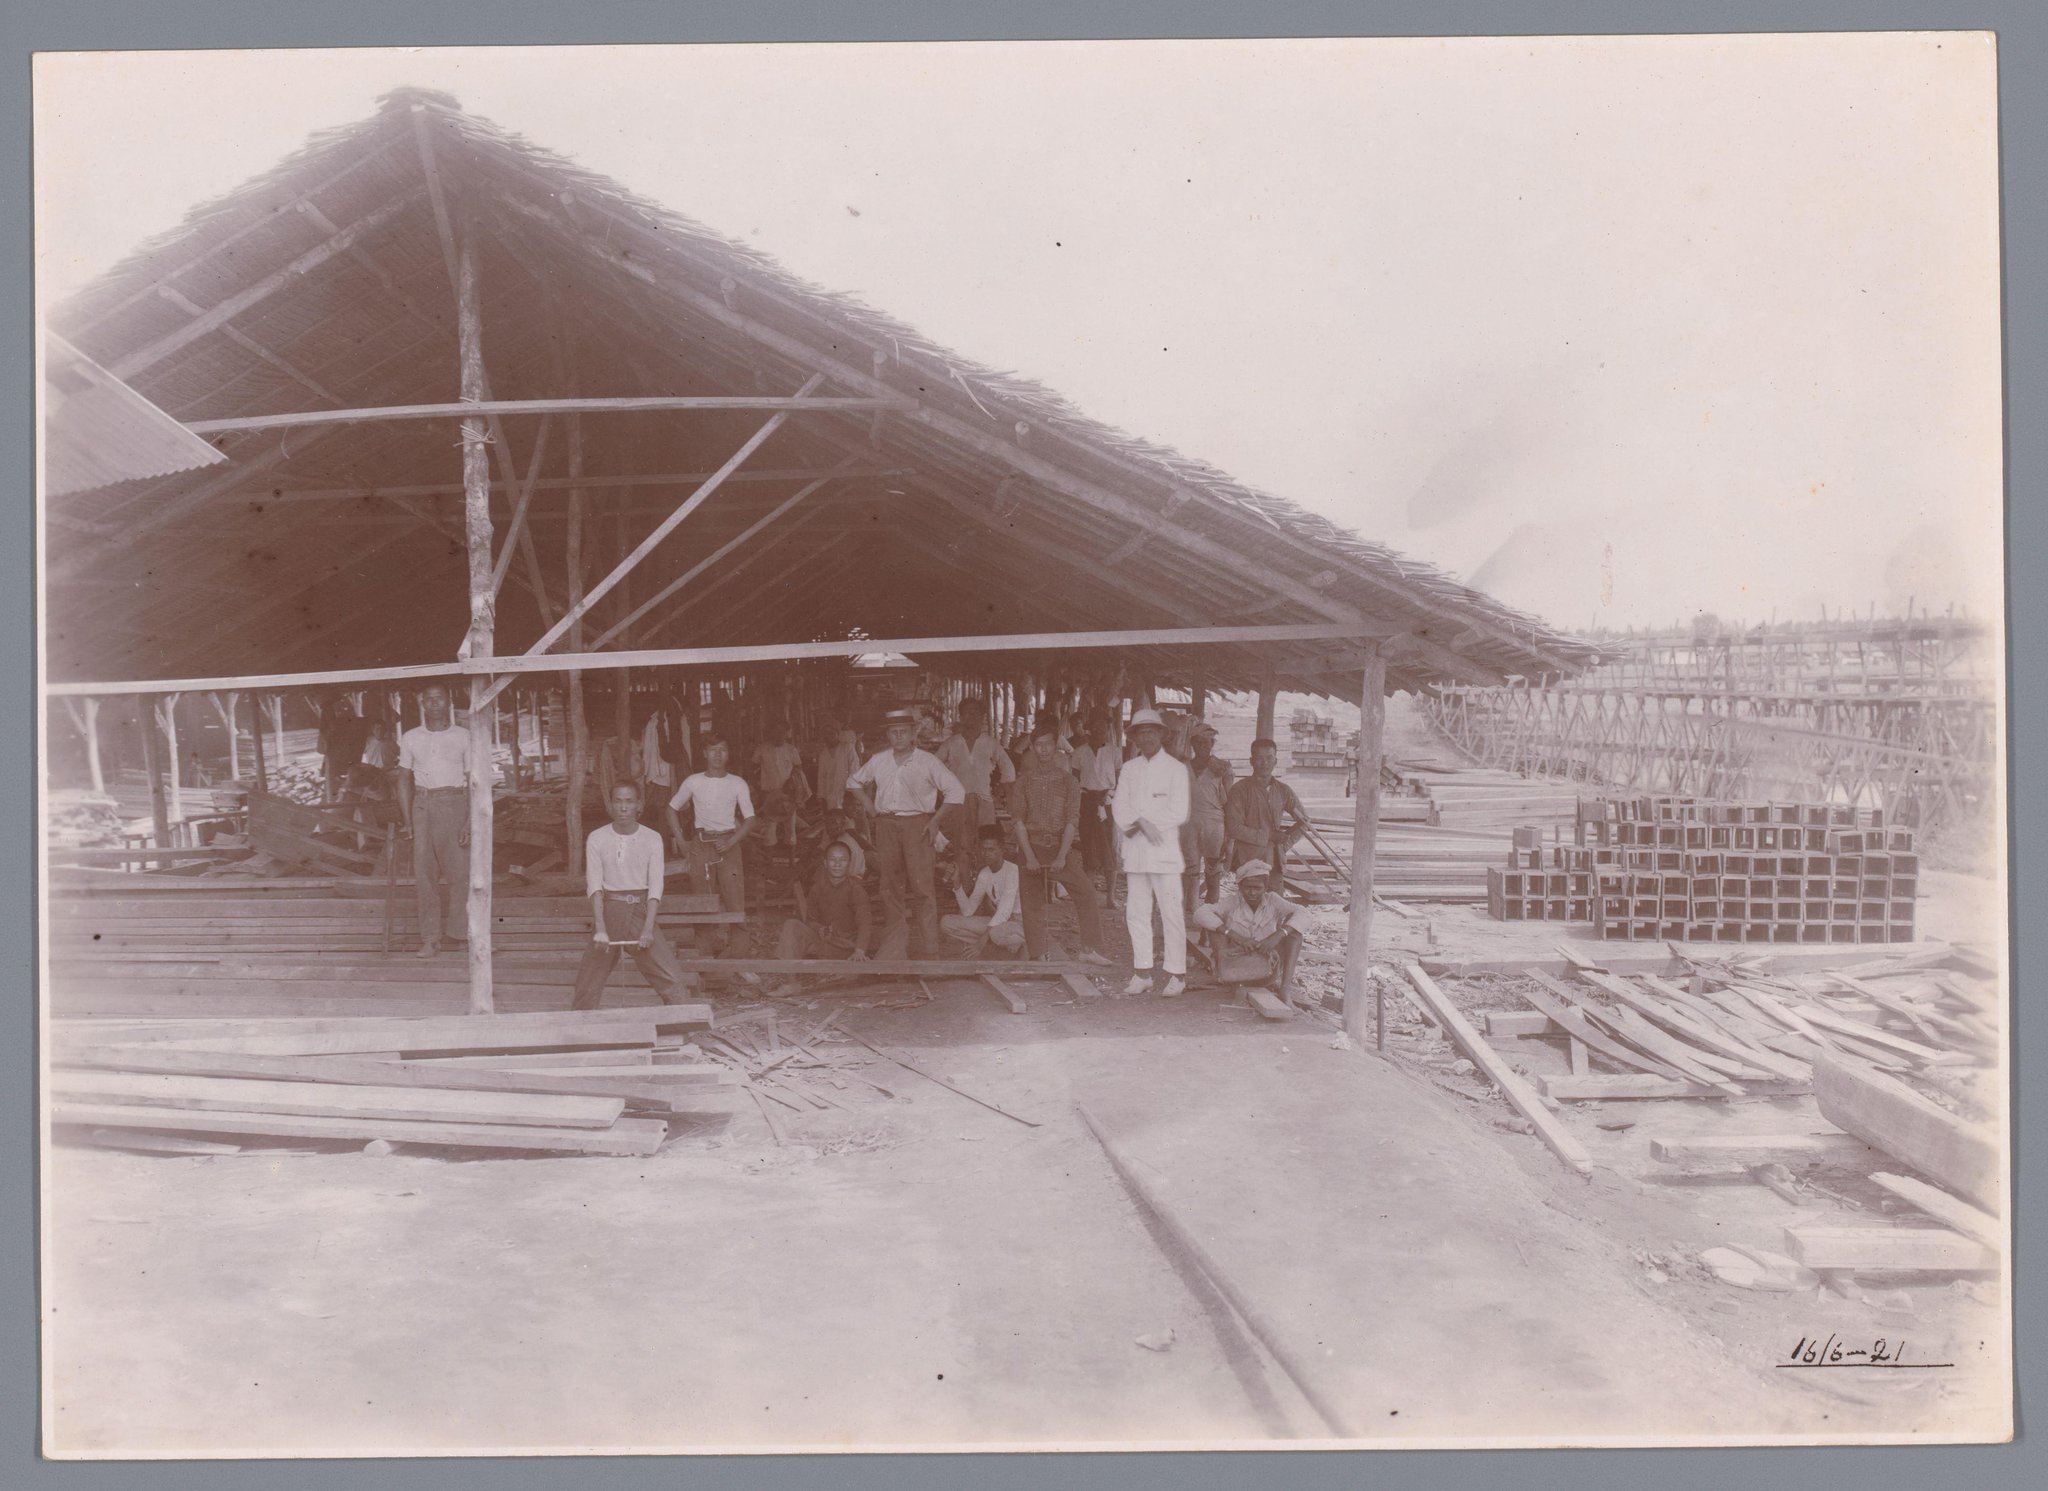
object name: photograph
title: Oceaanhaven Belawan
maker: Anonymous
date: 1921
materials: photographic support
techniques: gelatin silver print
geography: belawan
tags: harbour, building-site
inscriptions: inscription: ‘No. 23. Timmerloods’, date: ‘16/6-21’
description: Gezicht in de timmerloods met arbeiders en opzichters. Genummerd: 23. Onderdeel van de groep van losse foto's over de aanleg van de haven Belawan aan de kust voor Medan, Sumatra 1921-1922.